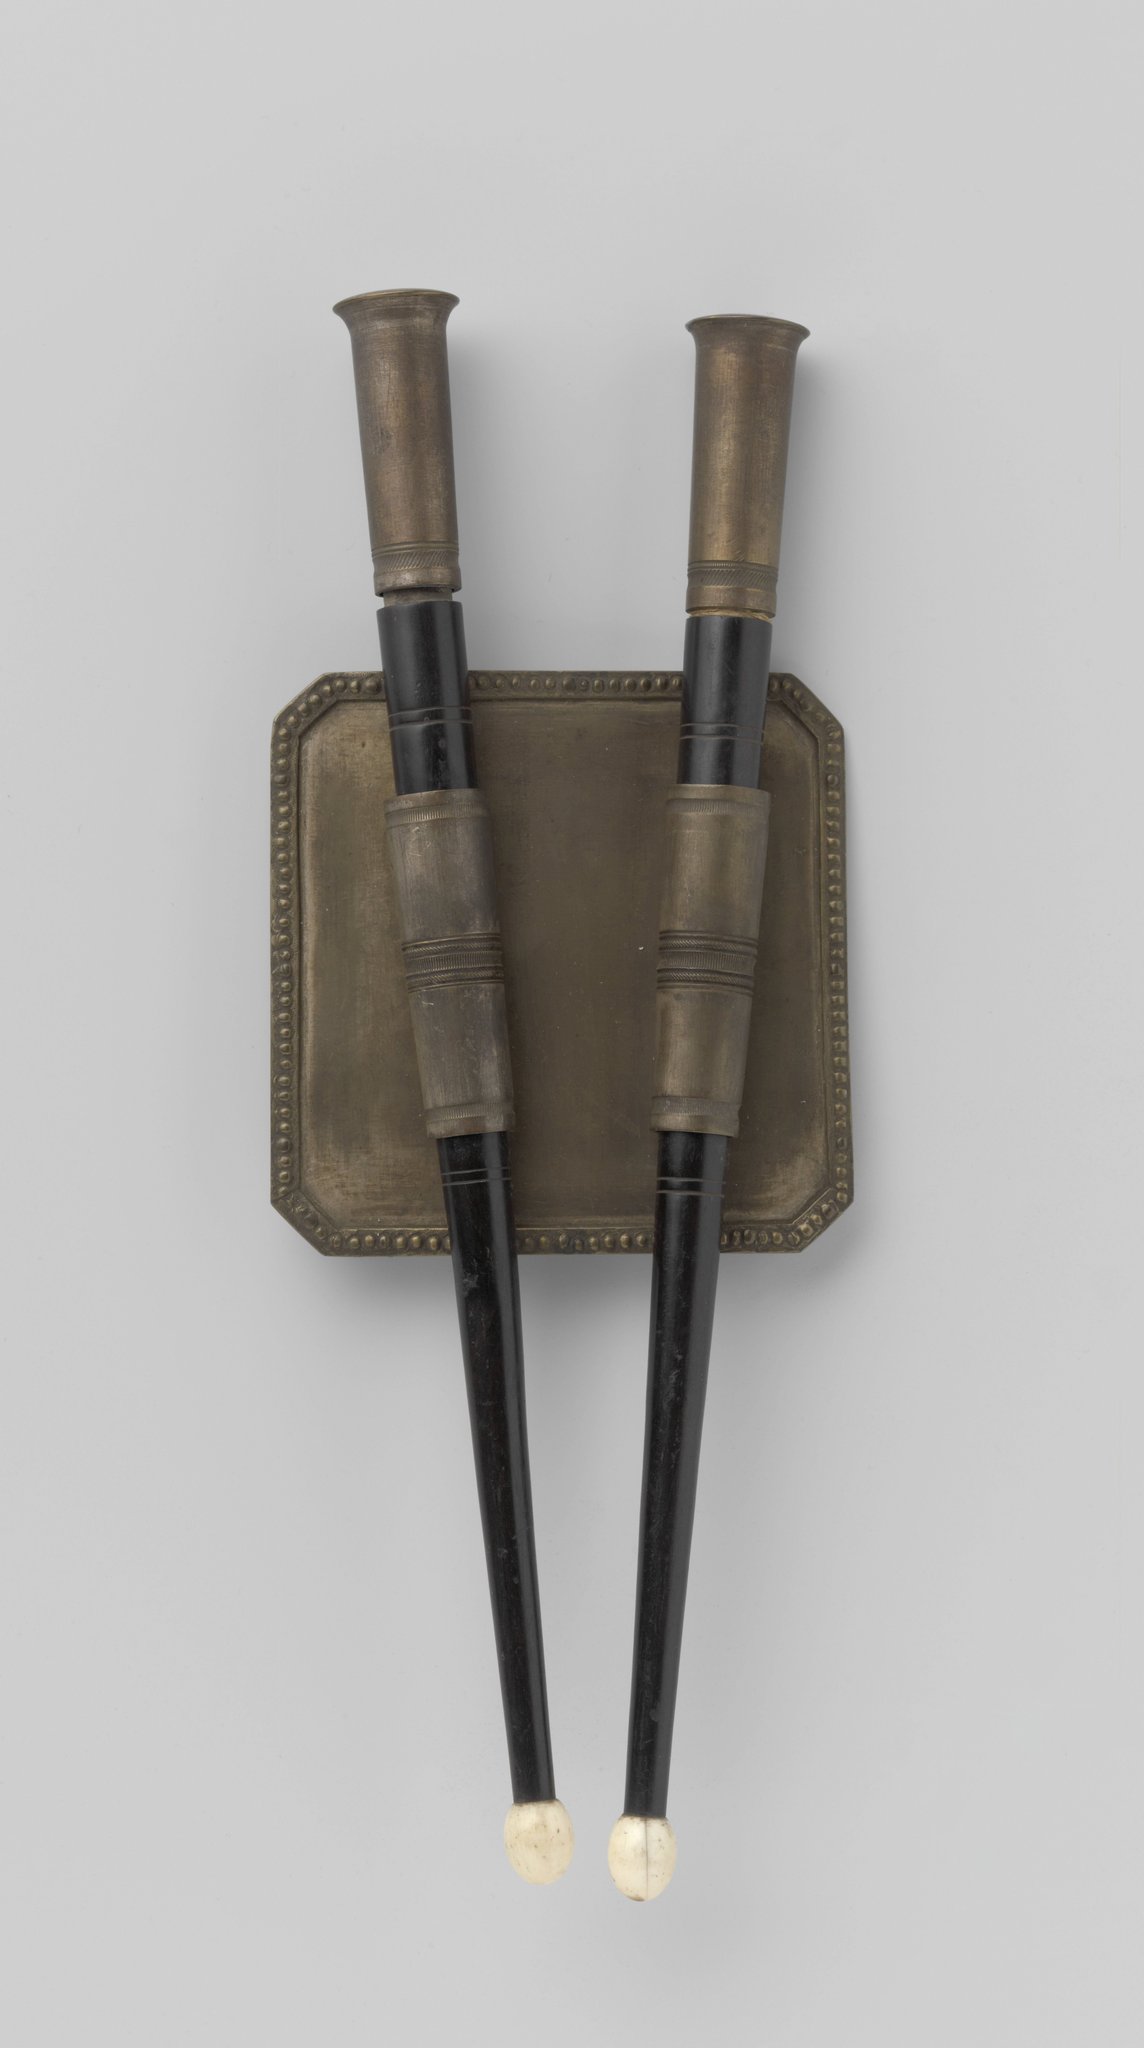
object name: percussion instrument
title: Drumsticks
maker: Anonymous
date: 1823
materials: copper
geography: netherlands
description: Stokplaat ven messing en trommelstokken voor tamboer-majoor.